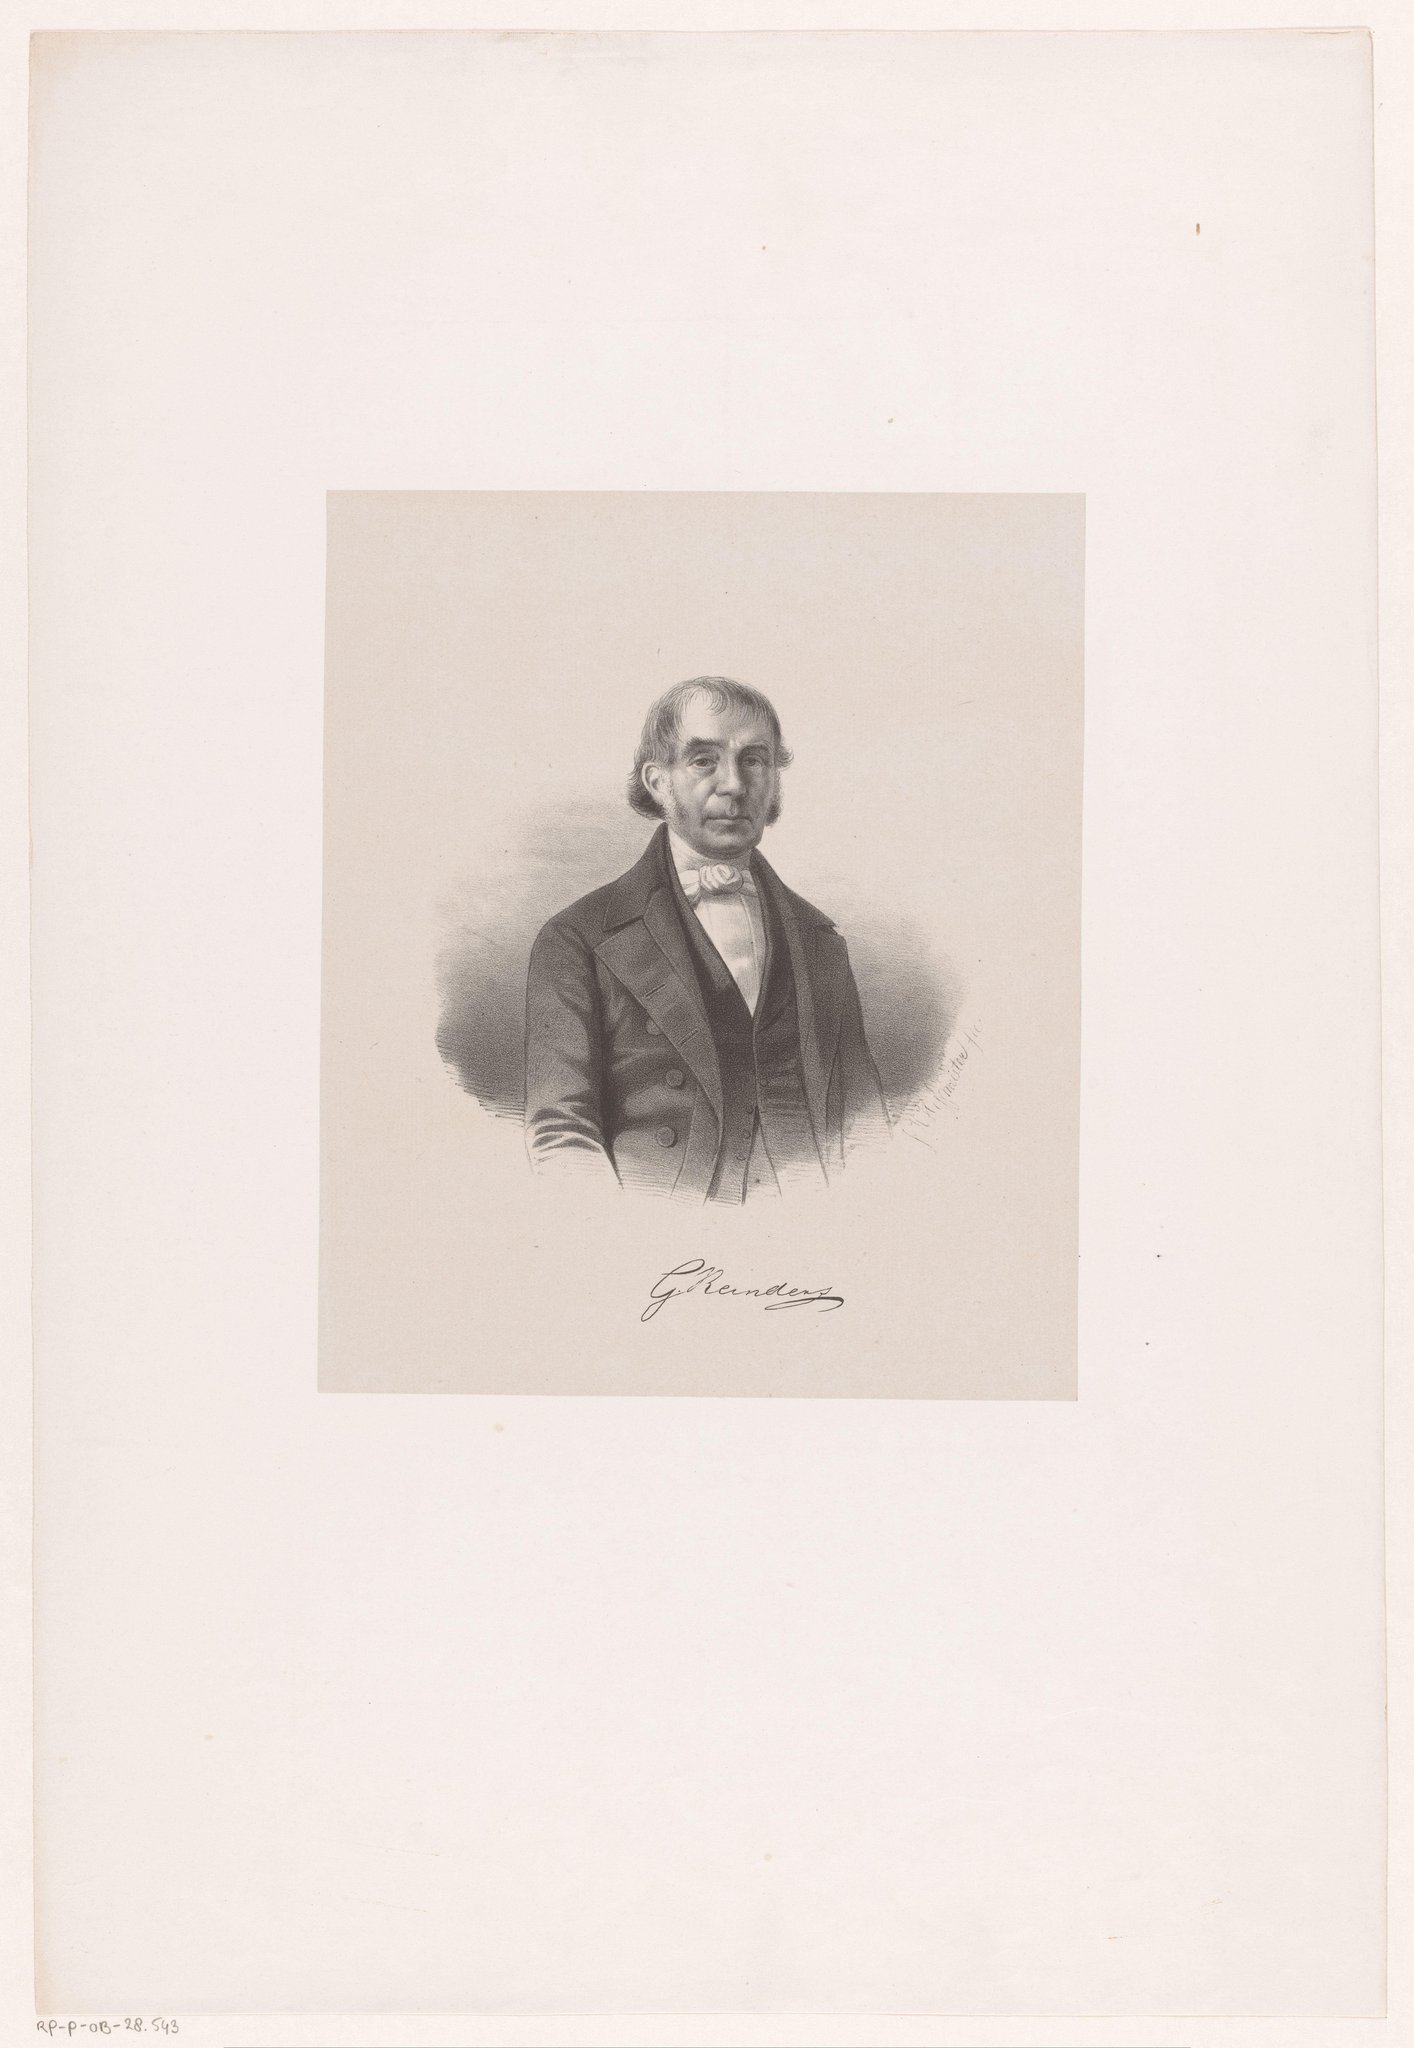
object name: print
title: Portret van Geert Reinders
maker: johan hendrik hoffmeister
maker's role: print maker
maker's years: 1823-1904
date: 1851-1883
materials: paper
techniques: lithograph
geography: the hague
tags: historical persons (+ (full) bust portrait)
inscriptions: collector's mark: Lugt 2228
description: Geert Reinders (1790-1869), van 1849 tot 1869 lid van de tweede kamer. Onder het portret de signatuur van de geportretteerde.